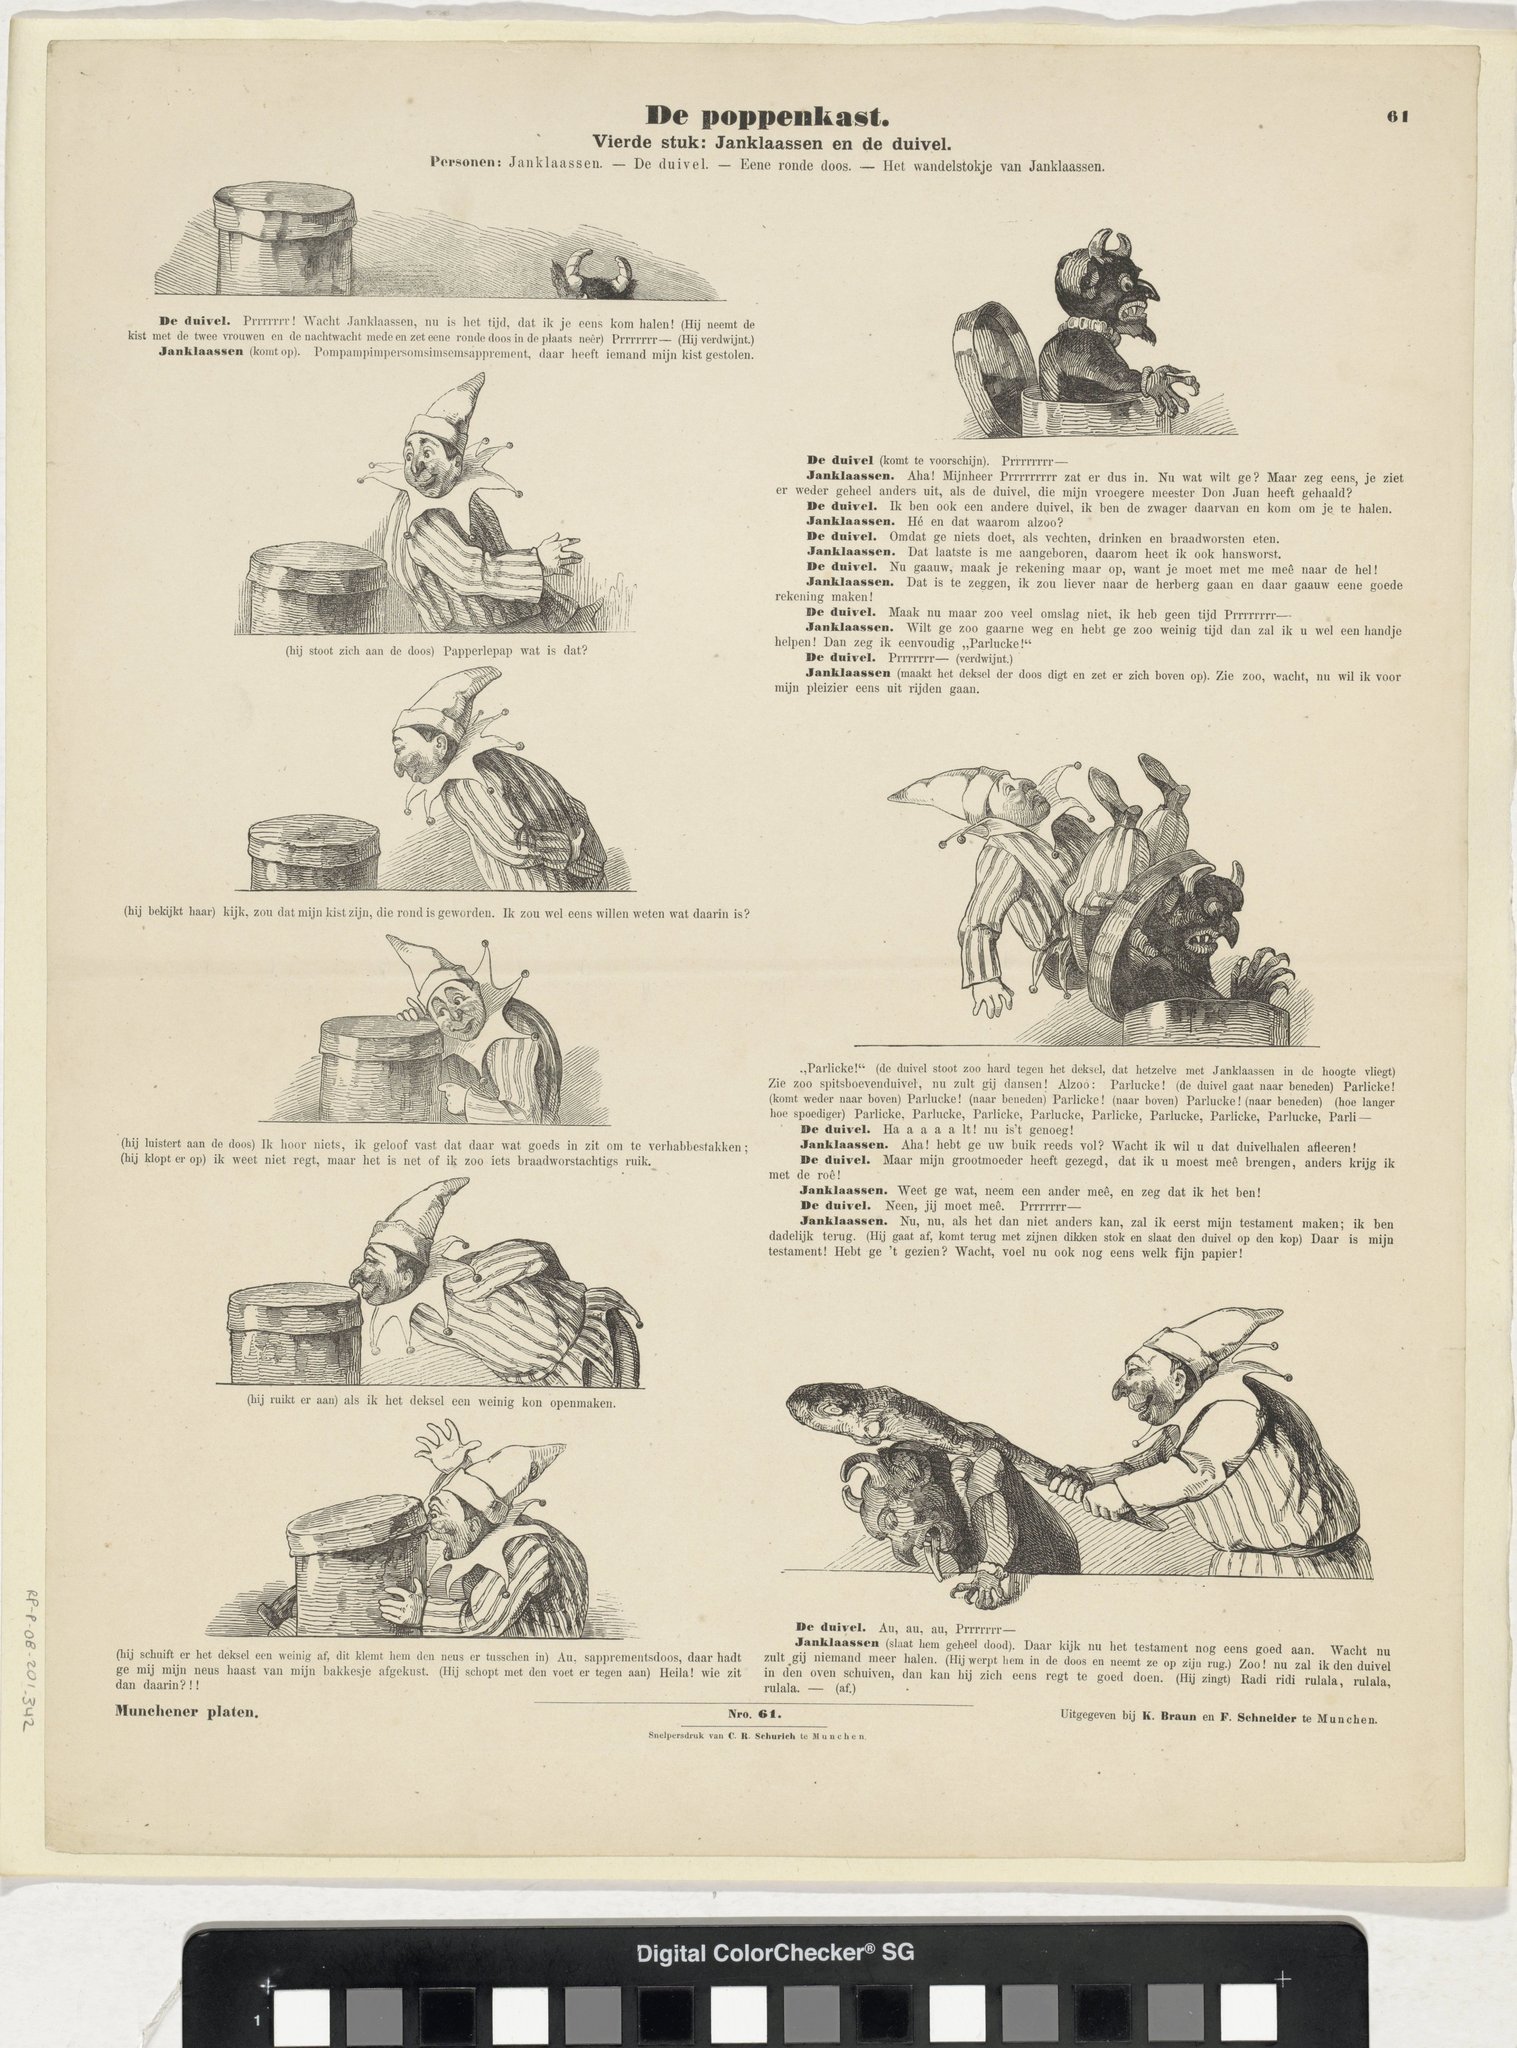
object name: print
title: Munchener platen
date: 1843-1920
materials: paper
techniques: letterpress printing, engraving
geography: germany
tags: puppet, punch and judy, devil(s) and demons, puppet and marionette show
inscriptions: collector's mark: Lugt 2760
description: Blad met 9 voorstellingen van poppenkastpoppen. Onder de afbeeldingen tekst voor een poppenkastvoorstelling. Genummerd midden onder: Nro. 61. Genummerd rechtsboven: 61.